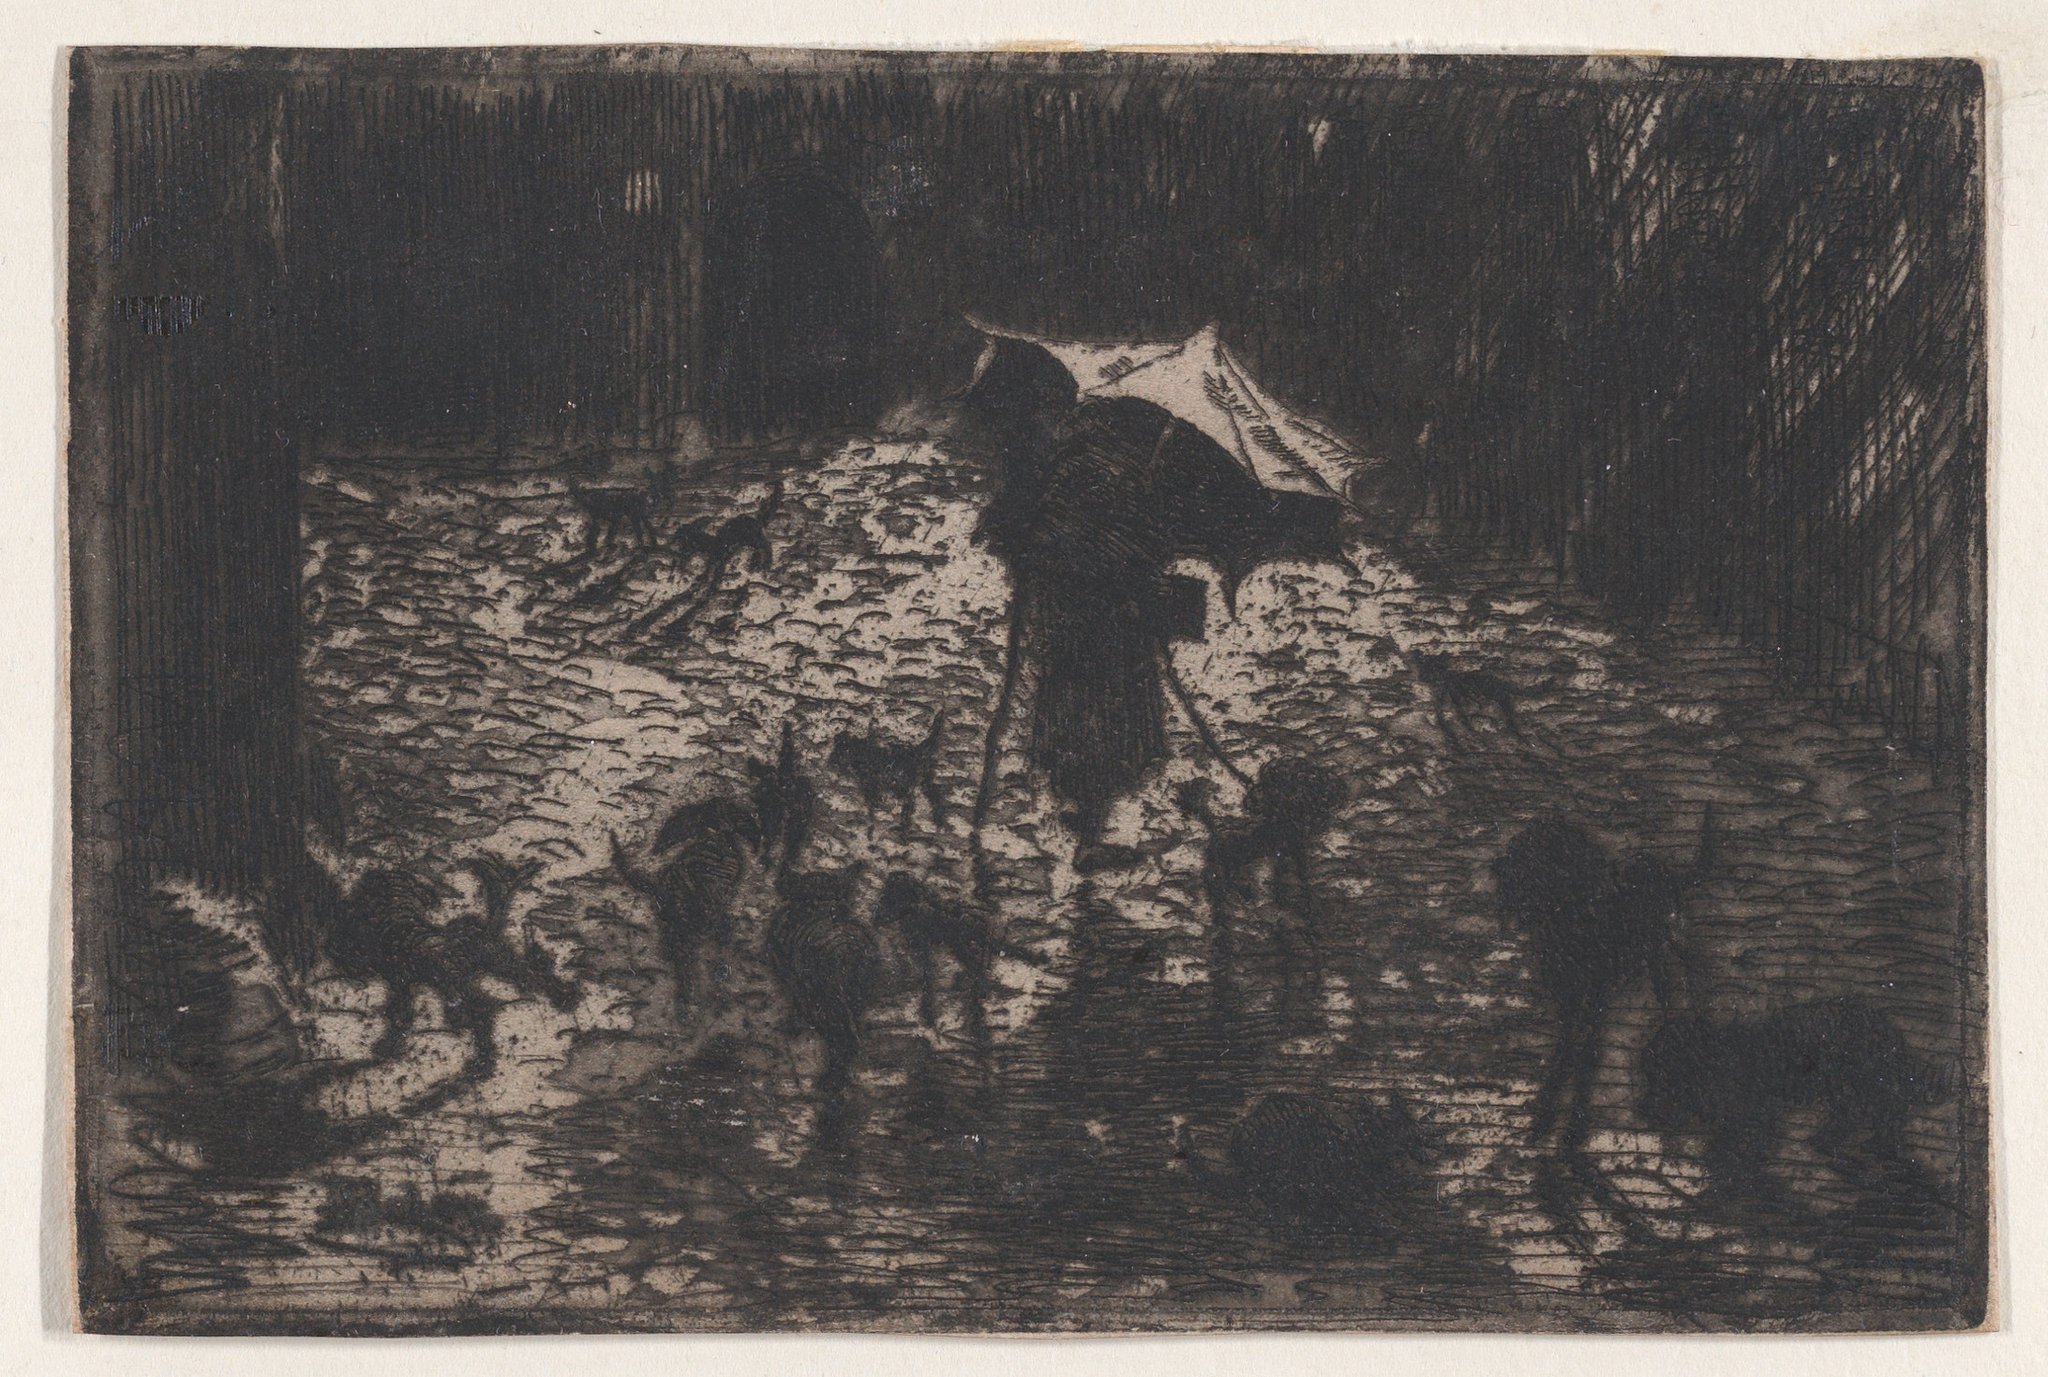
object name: print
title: The Night Prowlers (Les Noctambules)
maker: félix-hilaire buhot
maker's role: artist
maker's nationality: french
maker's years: 1847-1898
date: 1865-1898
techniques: etching